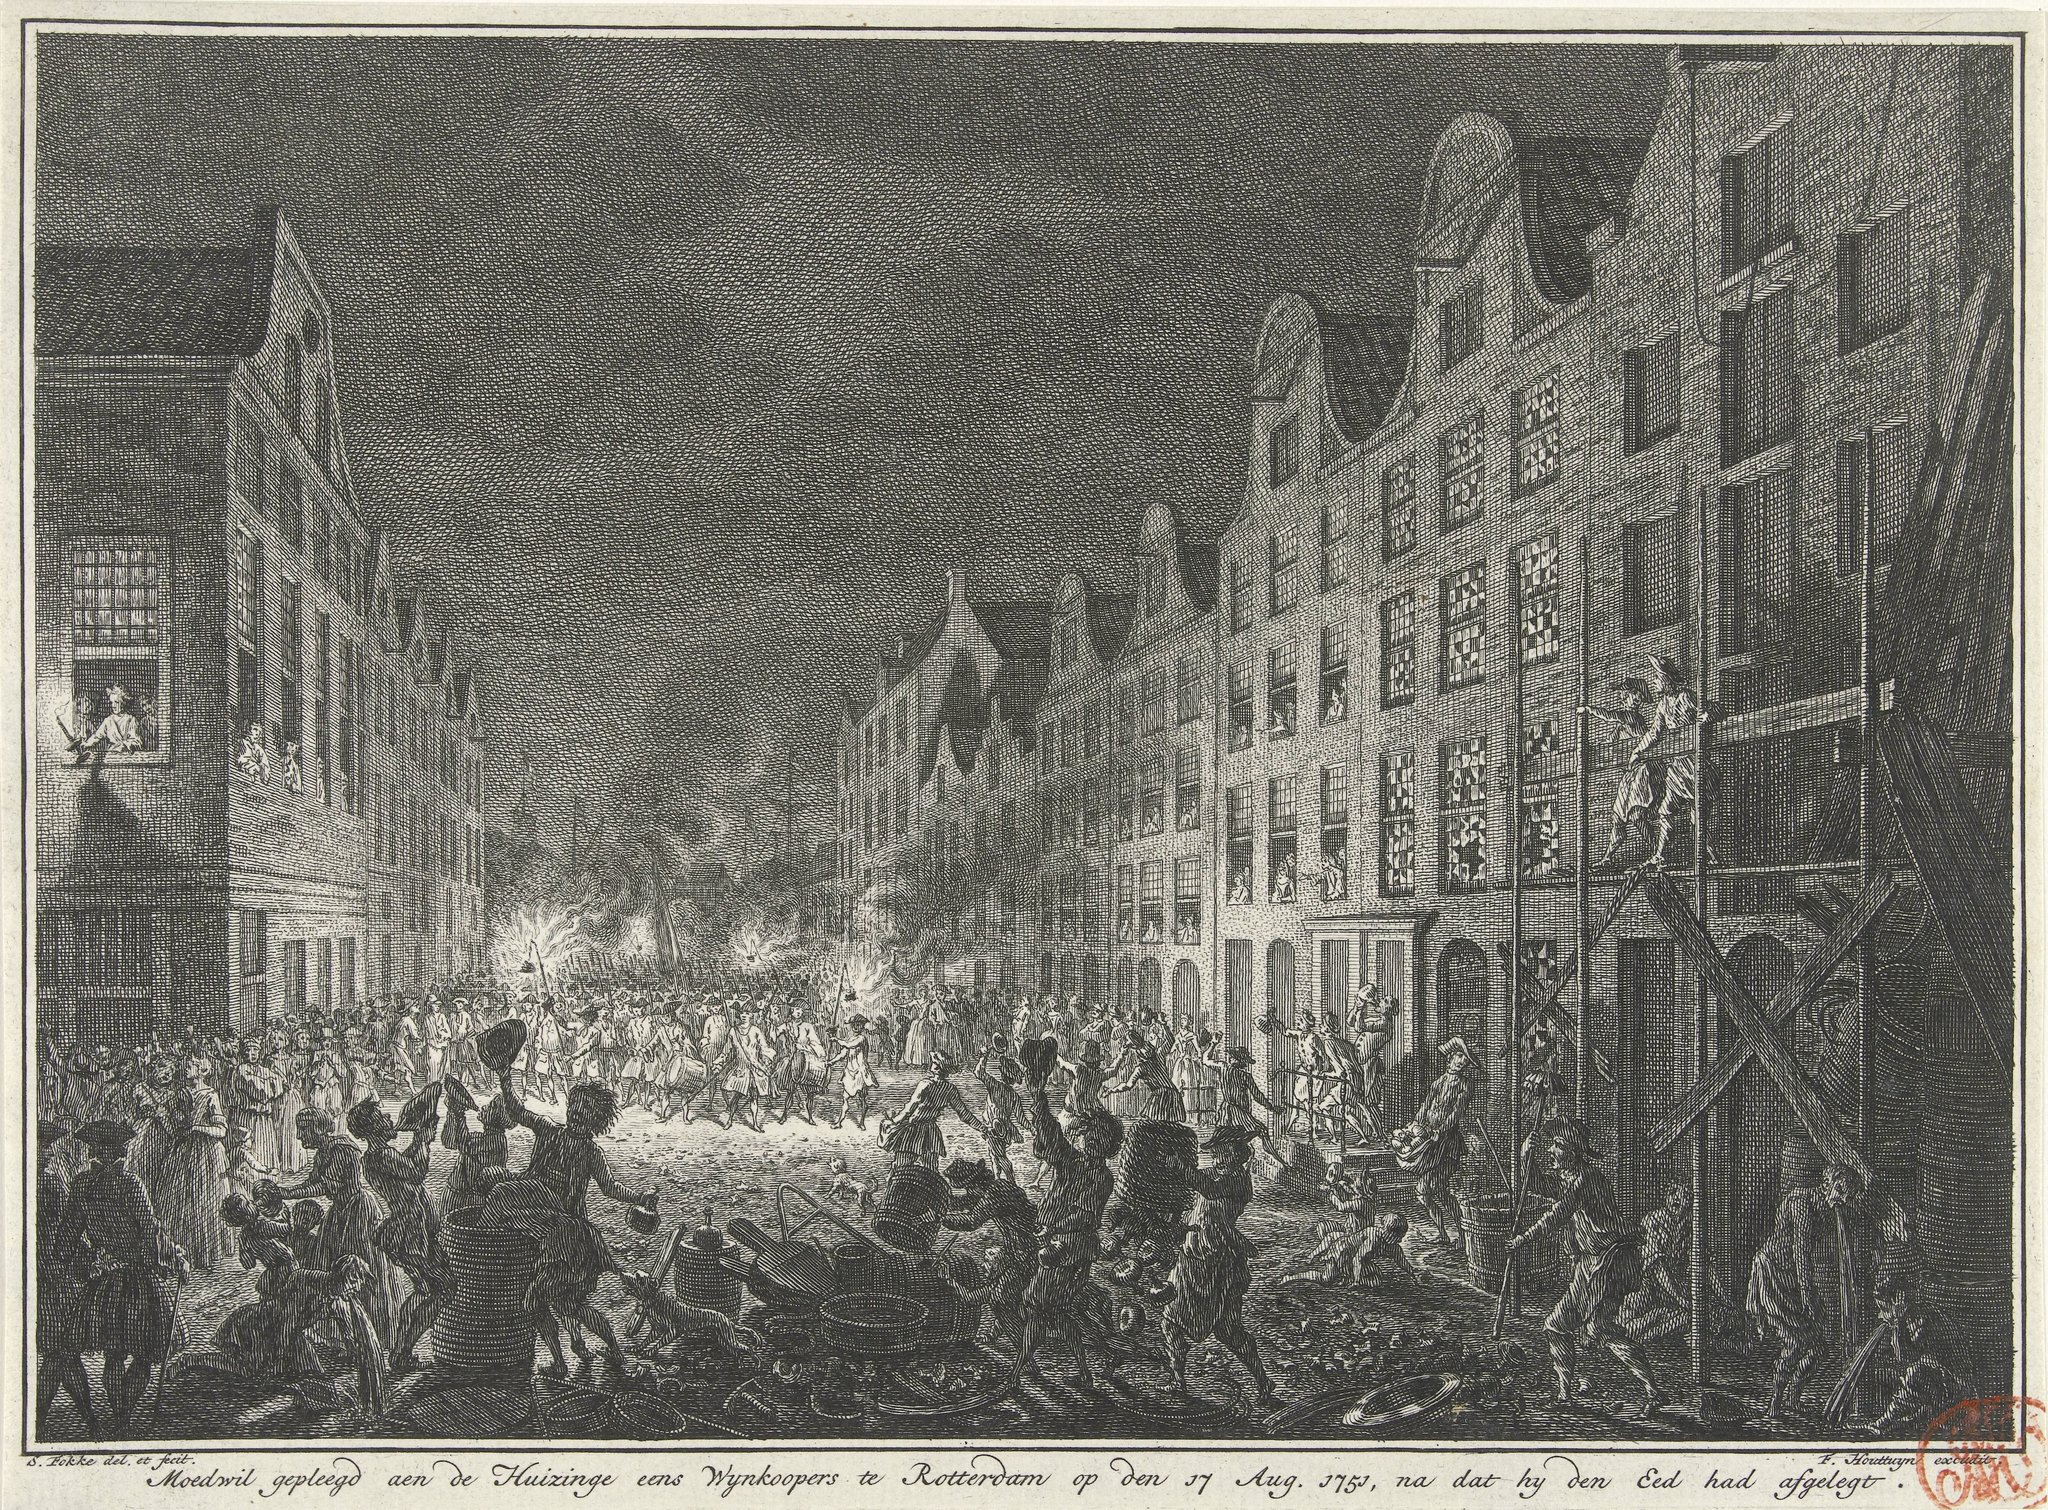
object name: print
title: Plundering van een wijnverkopershuis te Rotterdam, 1751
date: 1751-1753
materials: paper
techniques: etching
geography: amsterdam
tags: plundering ~ riot, rotterdam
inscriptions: collector's mark: Lugt 2228, collector's mark: Lugt 195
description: Straatgezicht met een plunderende menigte. Op de voorgrond staan opengebroken wijnvaten en figuren die wijn drinken.